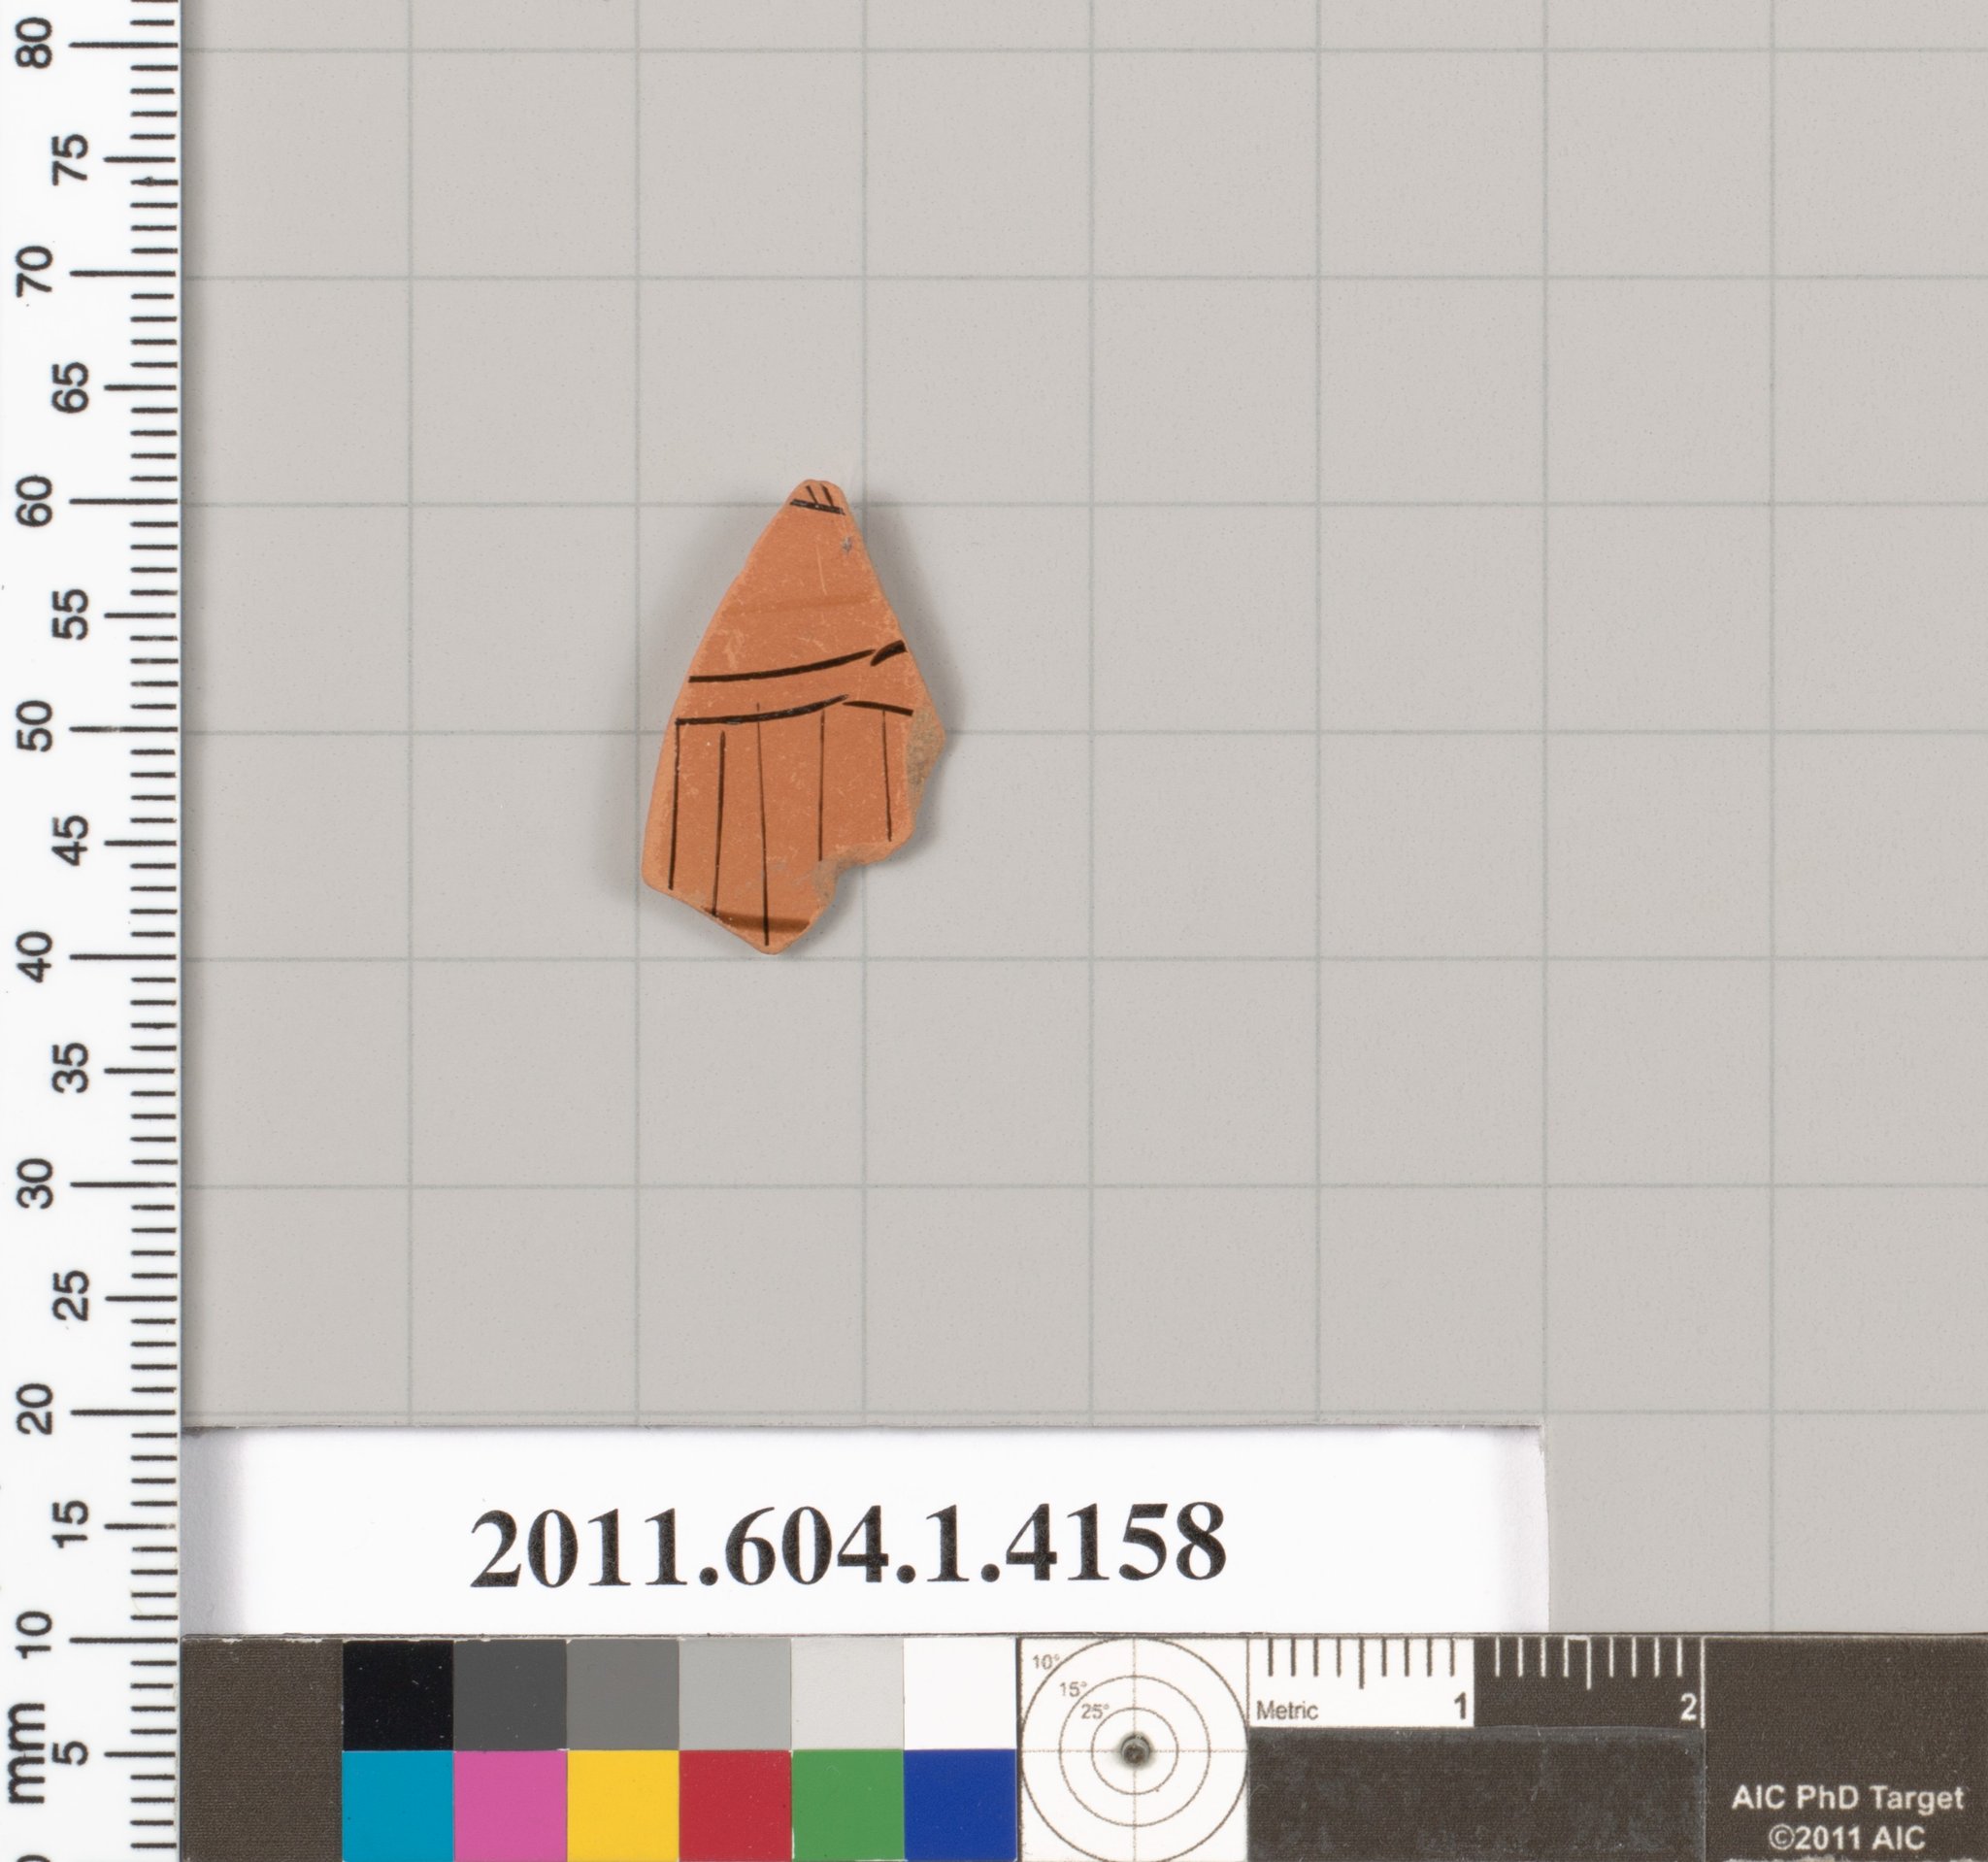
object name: kylix fragment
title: Terracotta fragment of a kylix (drinking cup)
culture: greek, attic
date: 475-451 BCE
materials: terracotta